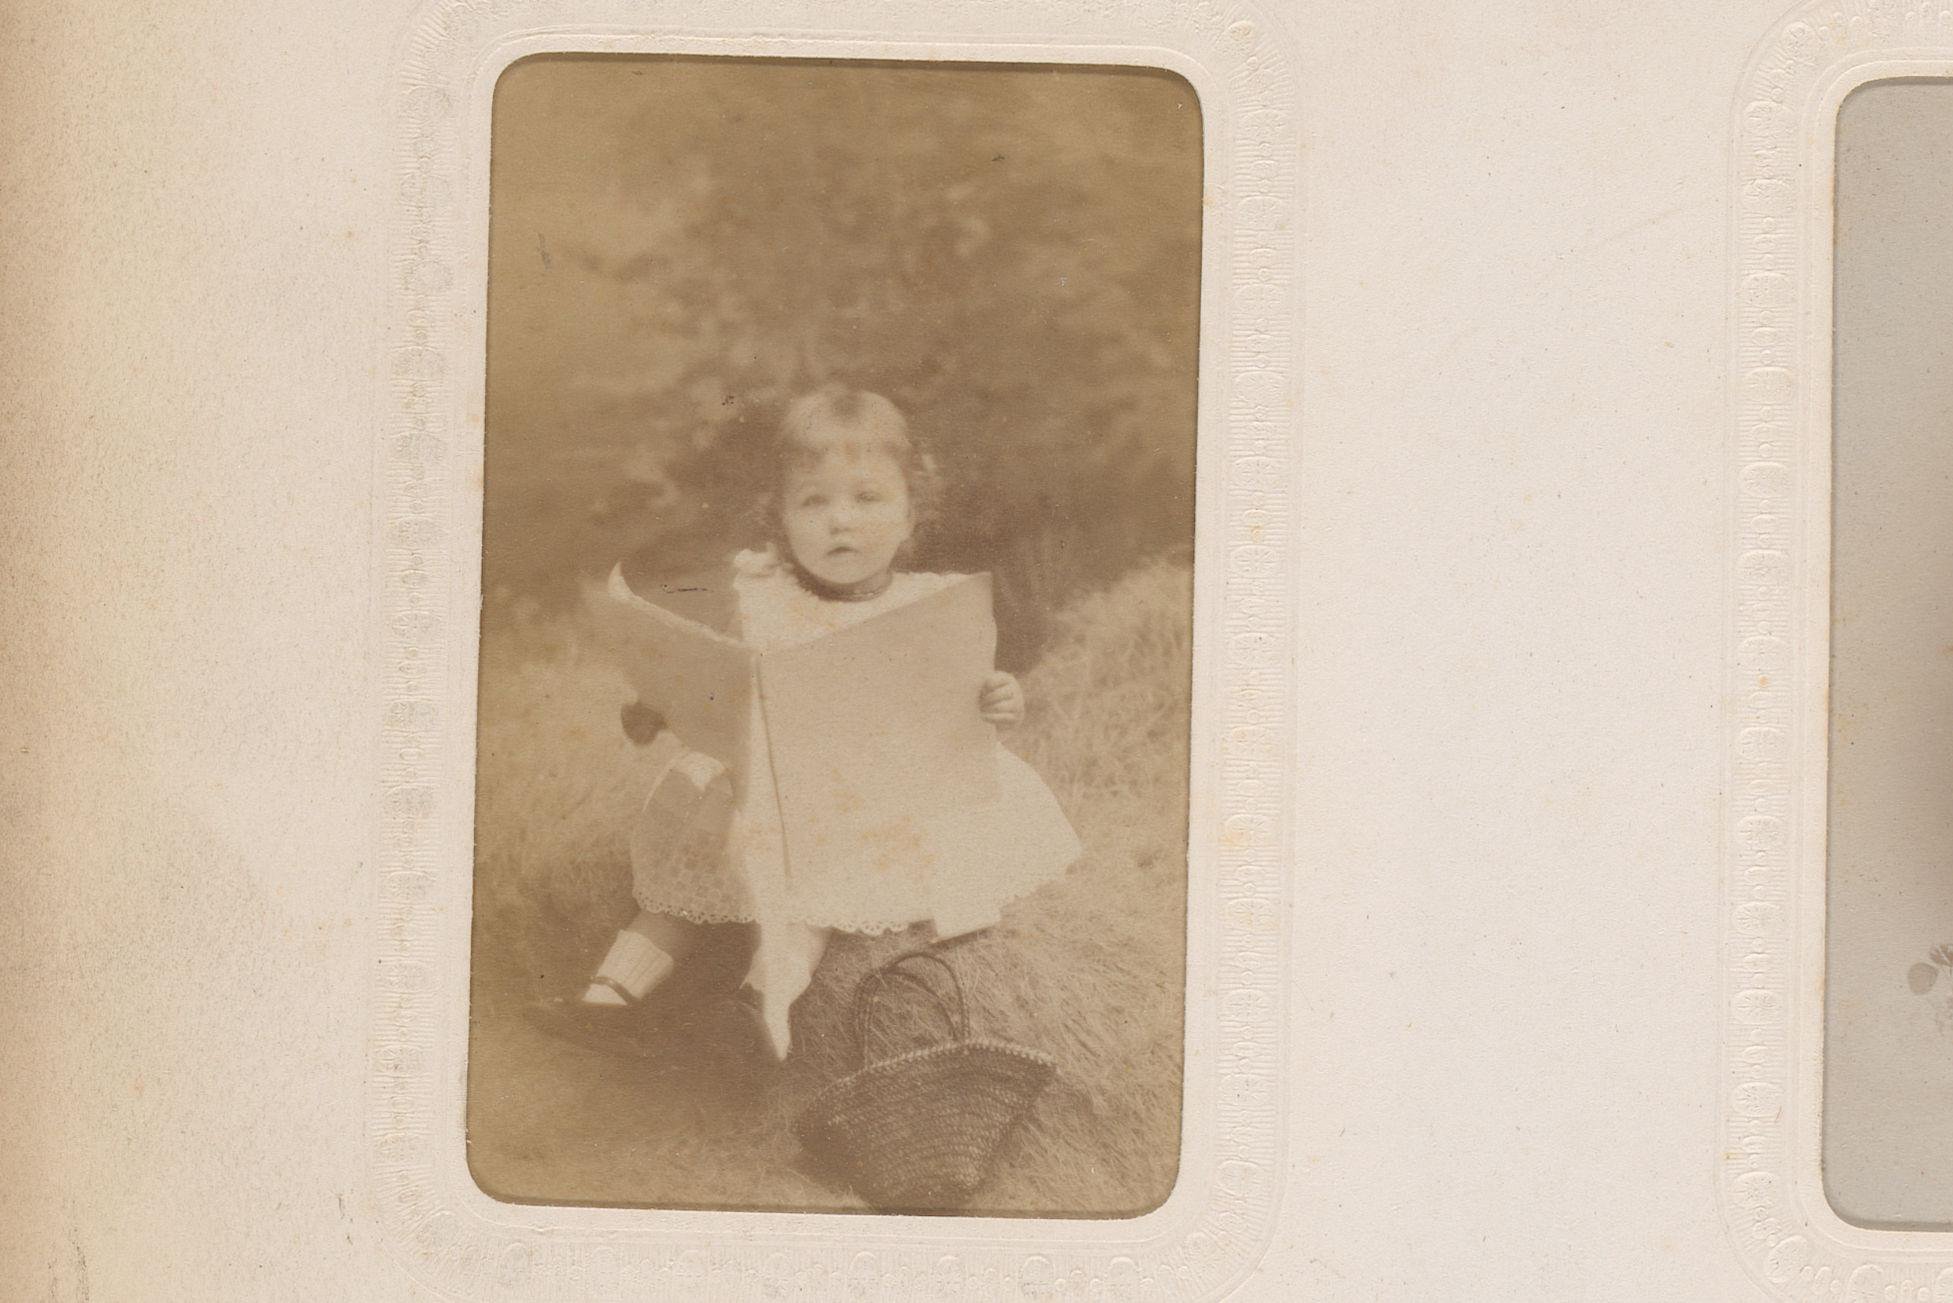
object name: photograph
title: Portret van een meisje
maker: Anonymous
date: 1880-1900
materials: cardboard, photographic support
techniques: collodion silver print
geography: netherlands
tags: historical persons - bb - woman, girl (child between toddler and youth)